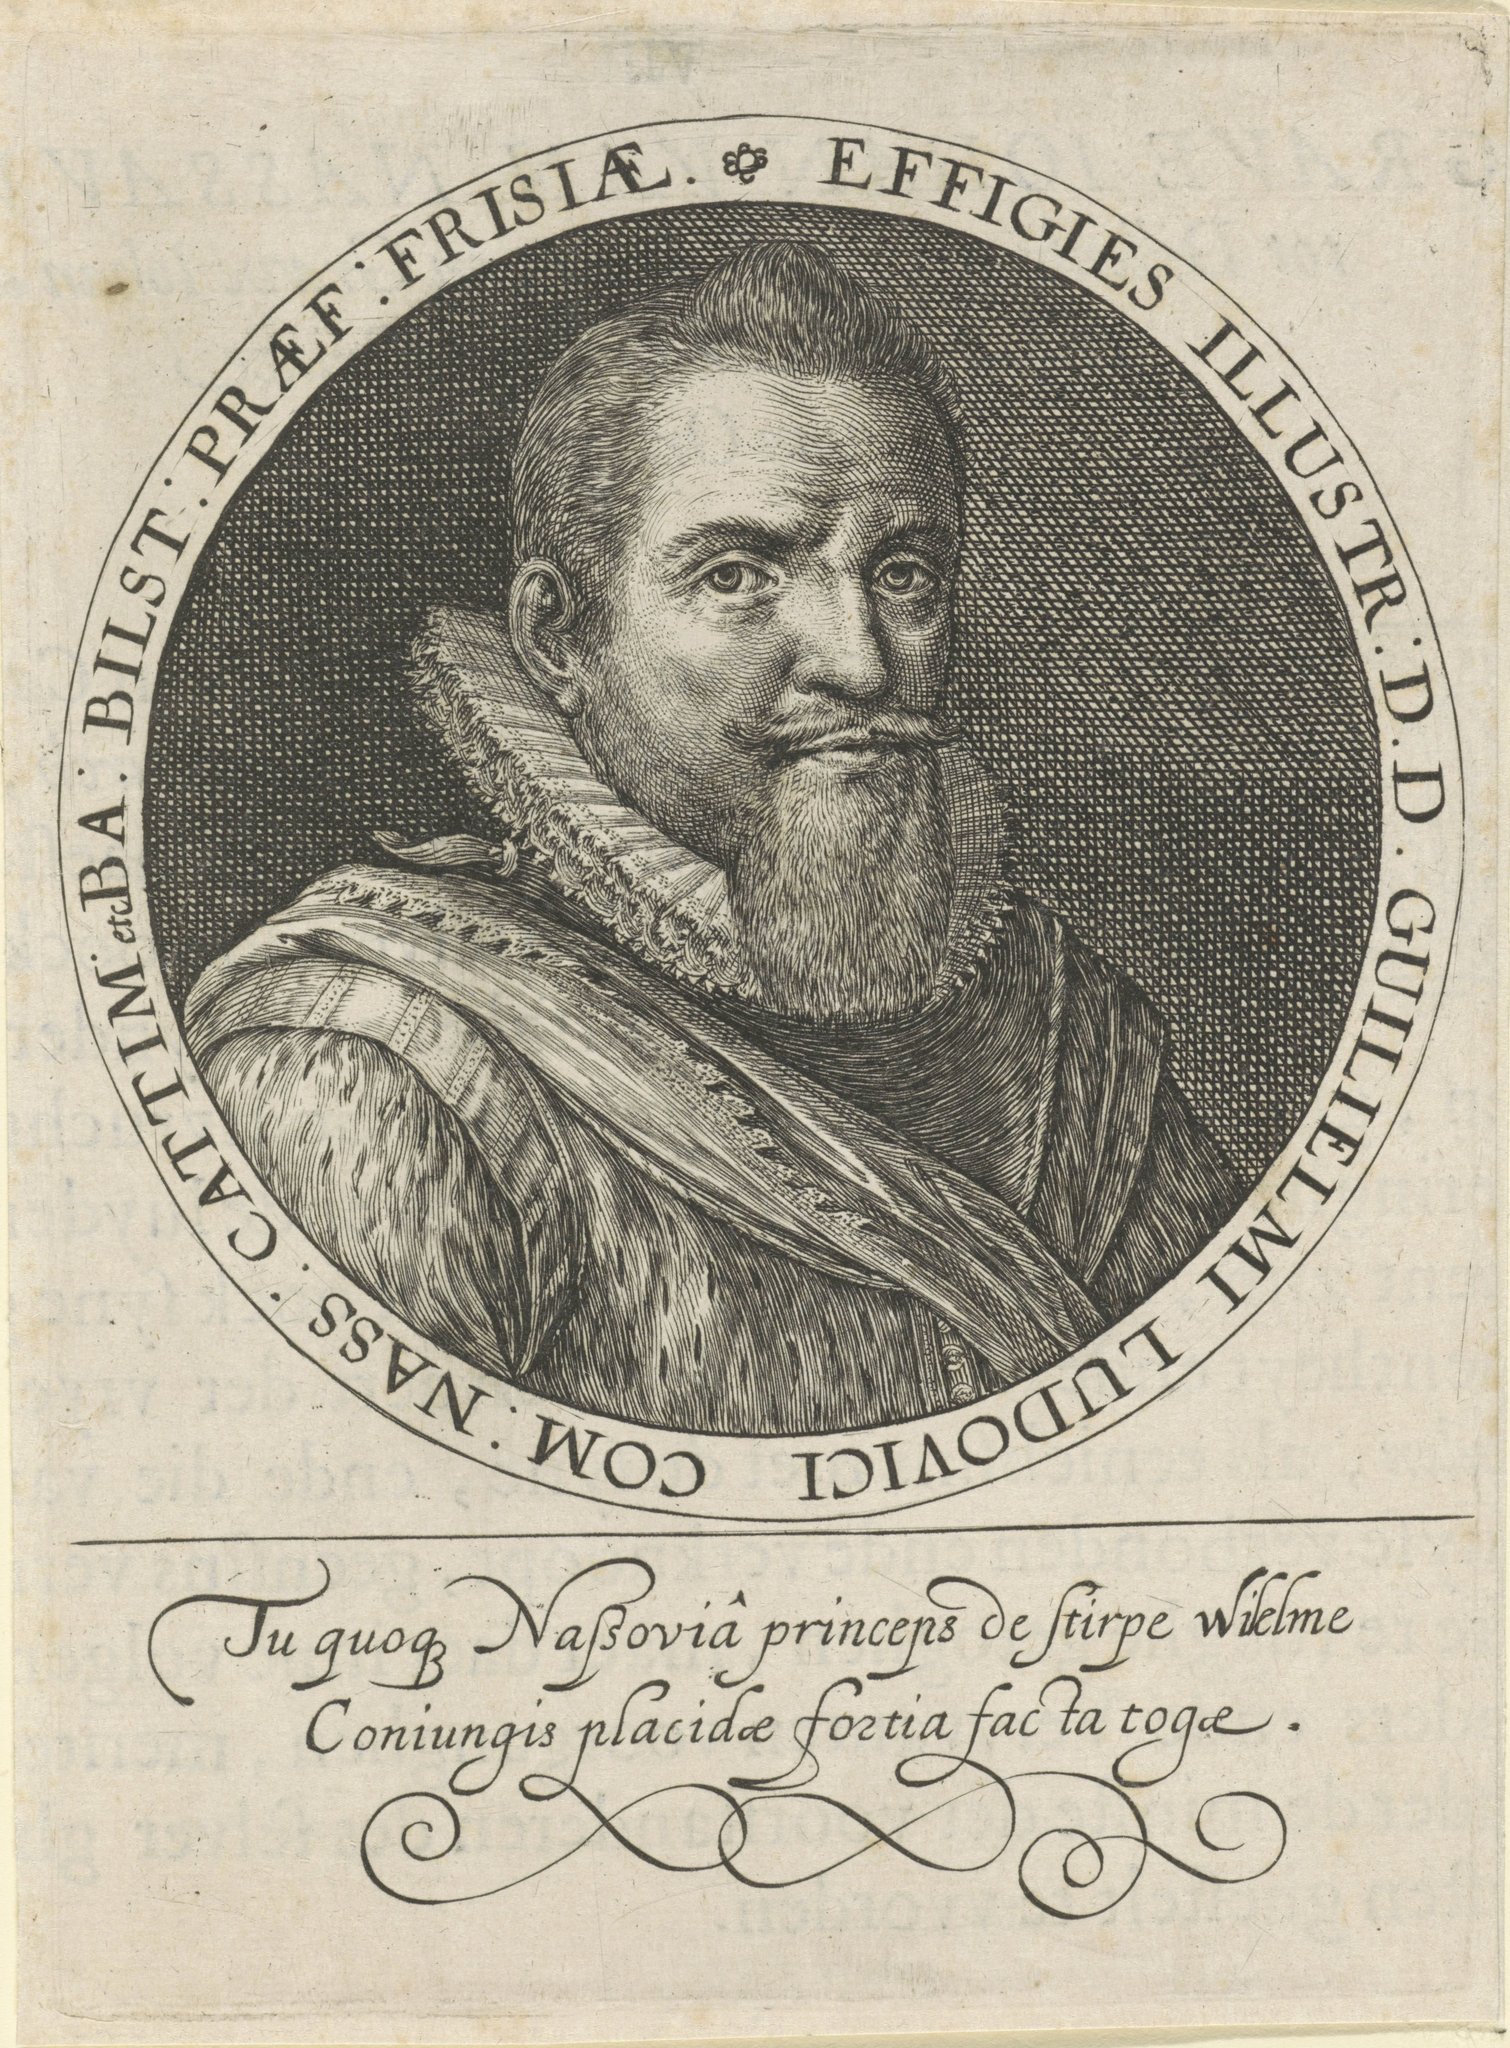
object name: book illustration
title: Portret van Willem Lodewijk, graaf van Nassau-Dillenburg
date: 1615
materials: paper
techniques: engraving, etching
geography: utrecht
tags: willem lodewijk graaf van nassau-dillenburg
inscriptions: collector's mark: Lugt 963, collector's mark: Lugt 2228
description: De hier vermelde titel verwijst naar de hoogst verkregen titel van de geportretteerde, niet per se naar de titel die de geportretteerde op deze voorstelling draagt. Prent uit: Buchelius, Arnoldus. Nassovischen Oraignen-boom, daer by ghevoecht, de conterfeytsels der voornaemster helden. = Malus Aurantius Nassovicus. Utrecht: Salomon de Roy, 1615.